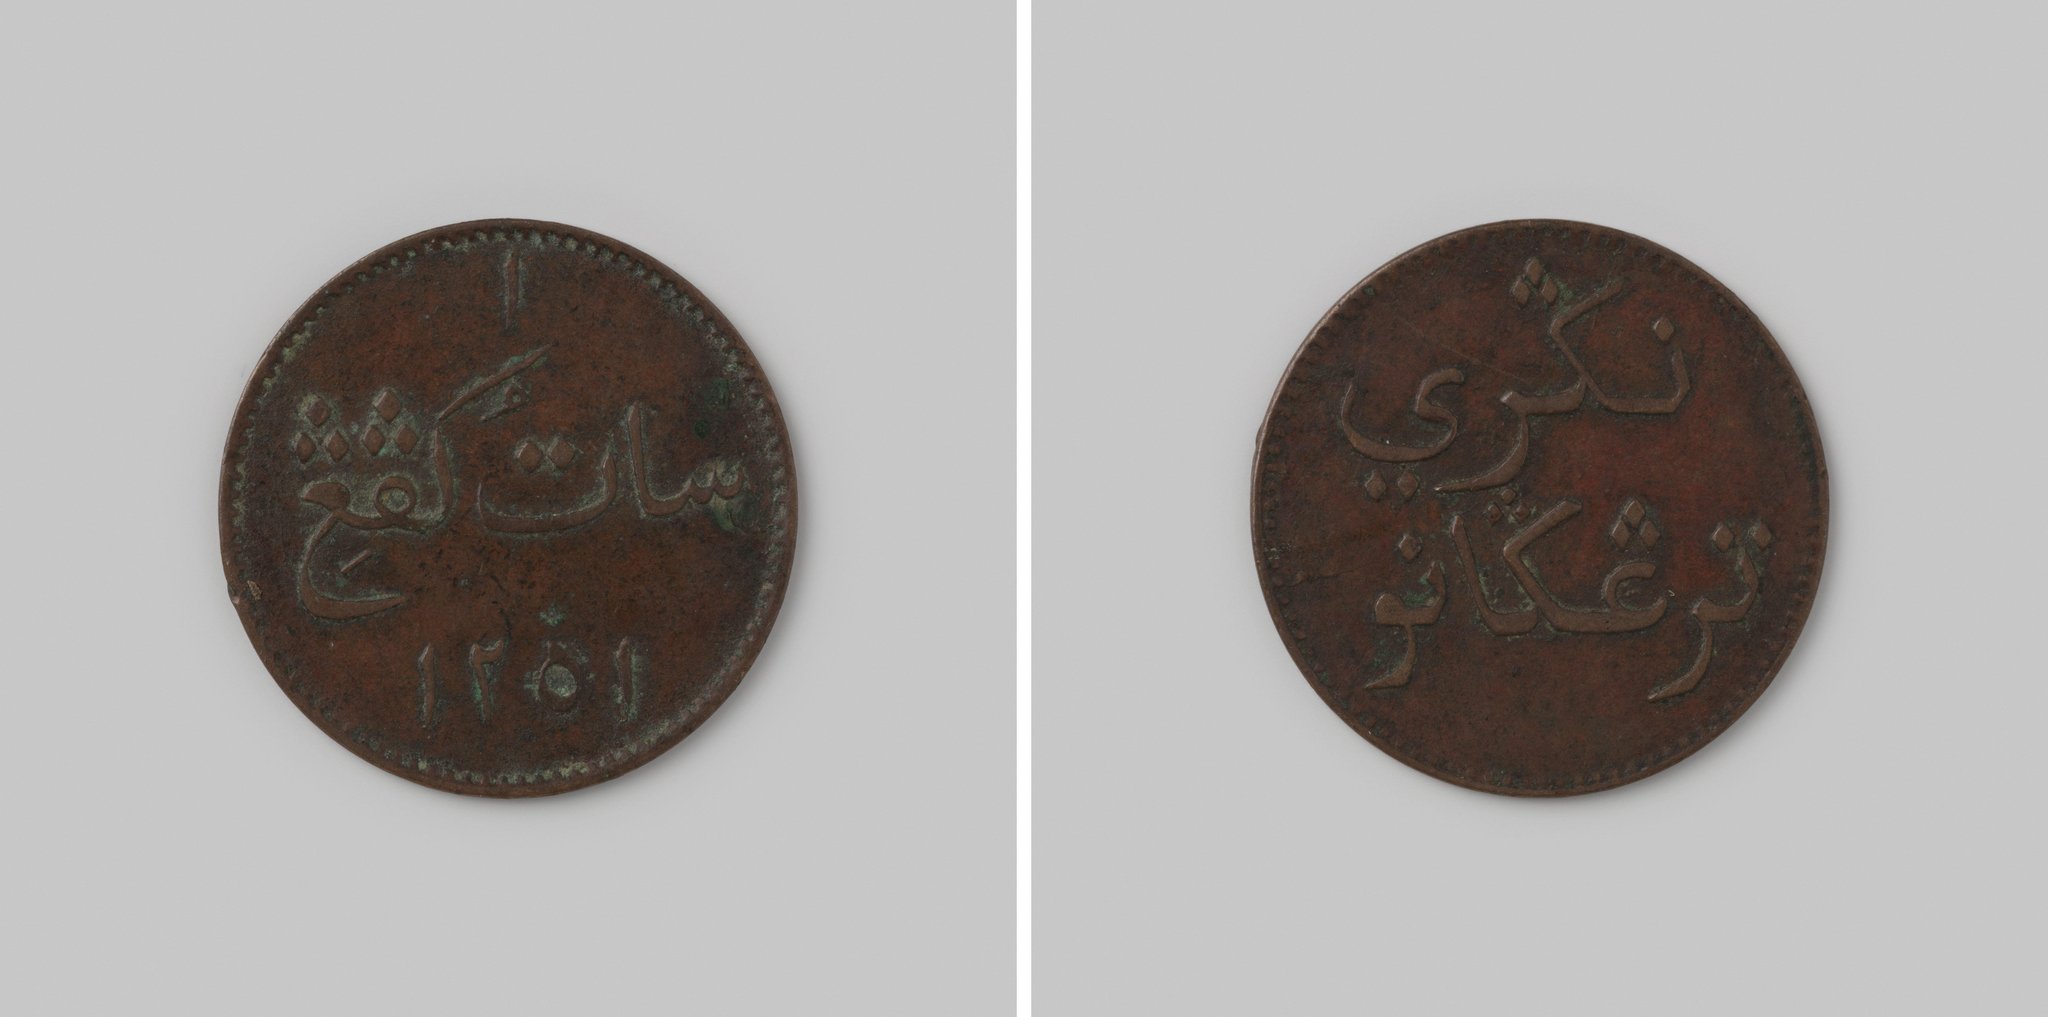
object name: coin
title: Kepeng uit Malakka voor Trengganu,1251 [=1835]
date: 1835-1836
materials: copper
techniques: striking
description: Koperen particuliere munt. Voorzijde: in een regel waarde-aaanduiding sat kepeng in Arabische lettertekens, waarboven 1/1. Onderaan jaartal: 1251. Keerzijde: in twee regels lands-aanduiding Negri Trengganu in Arabische letttertekens. Gladde rand.